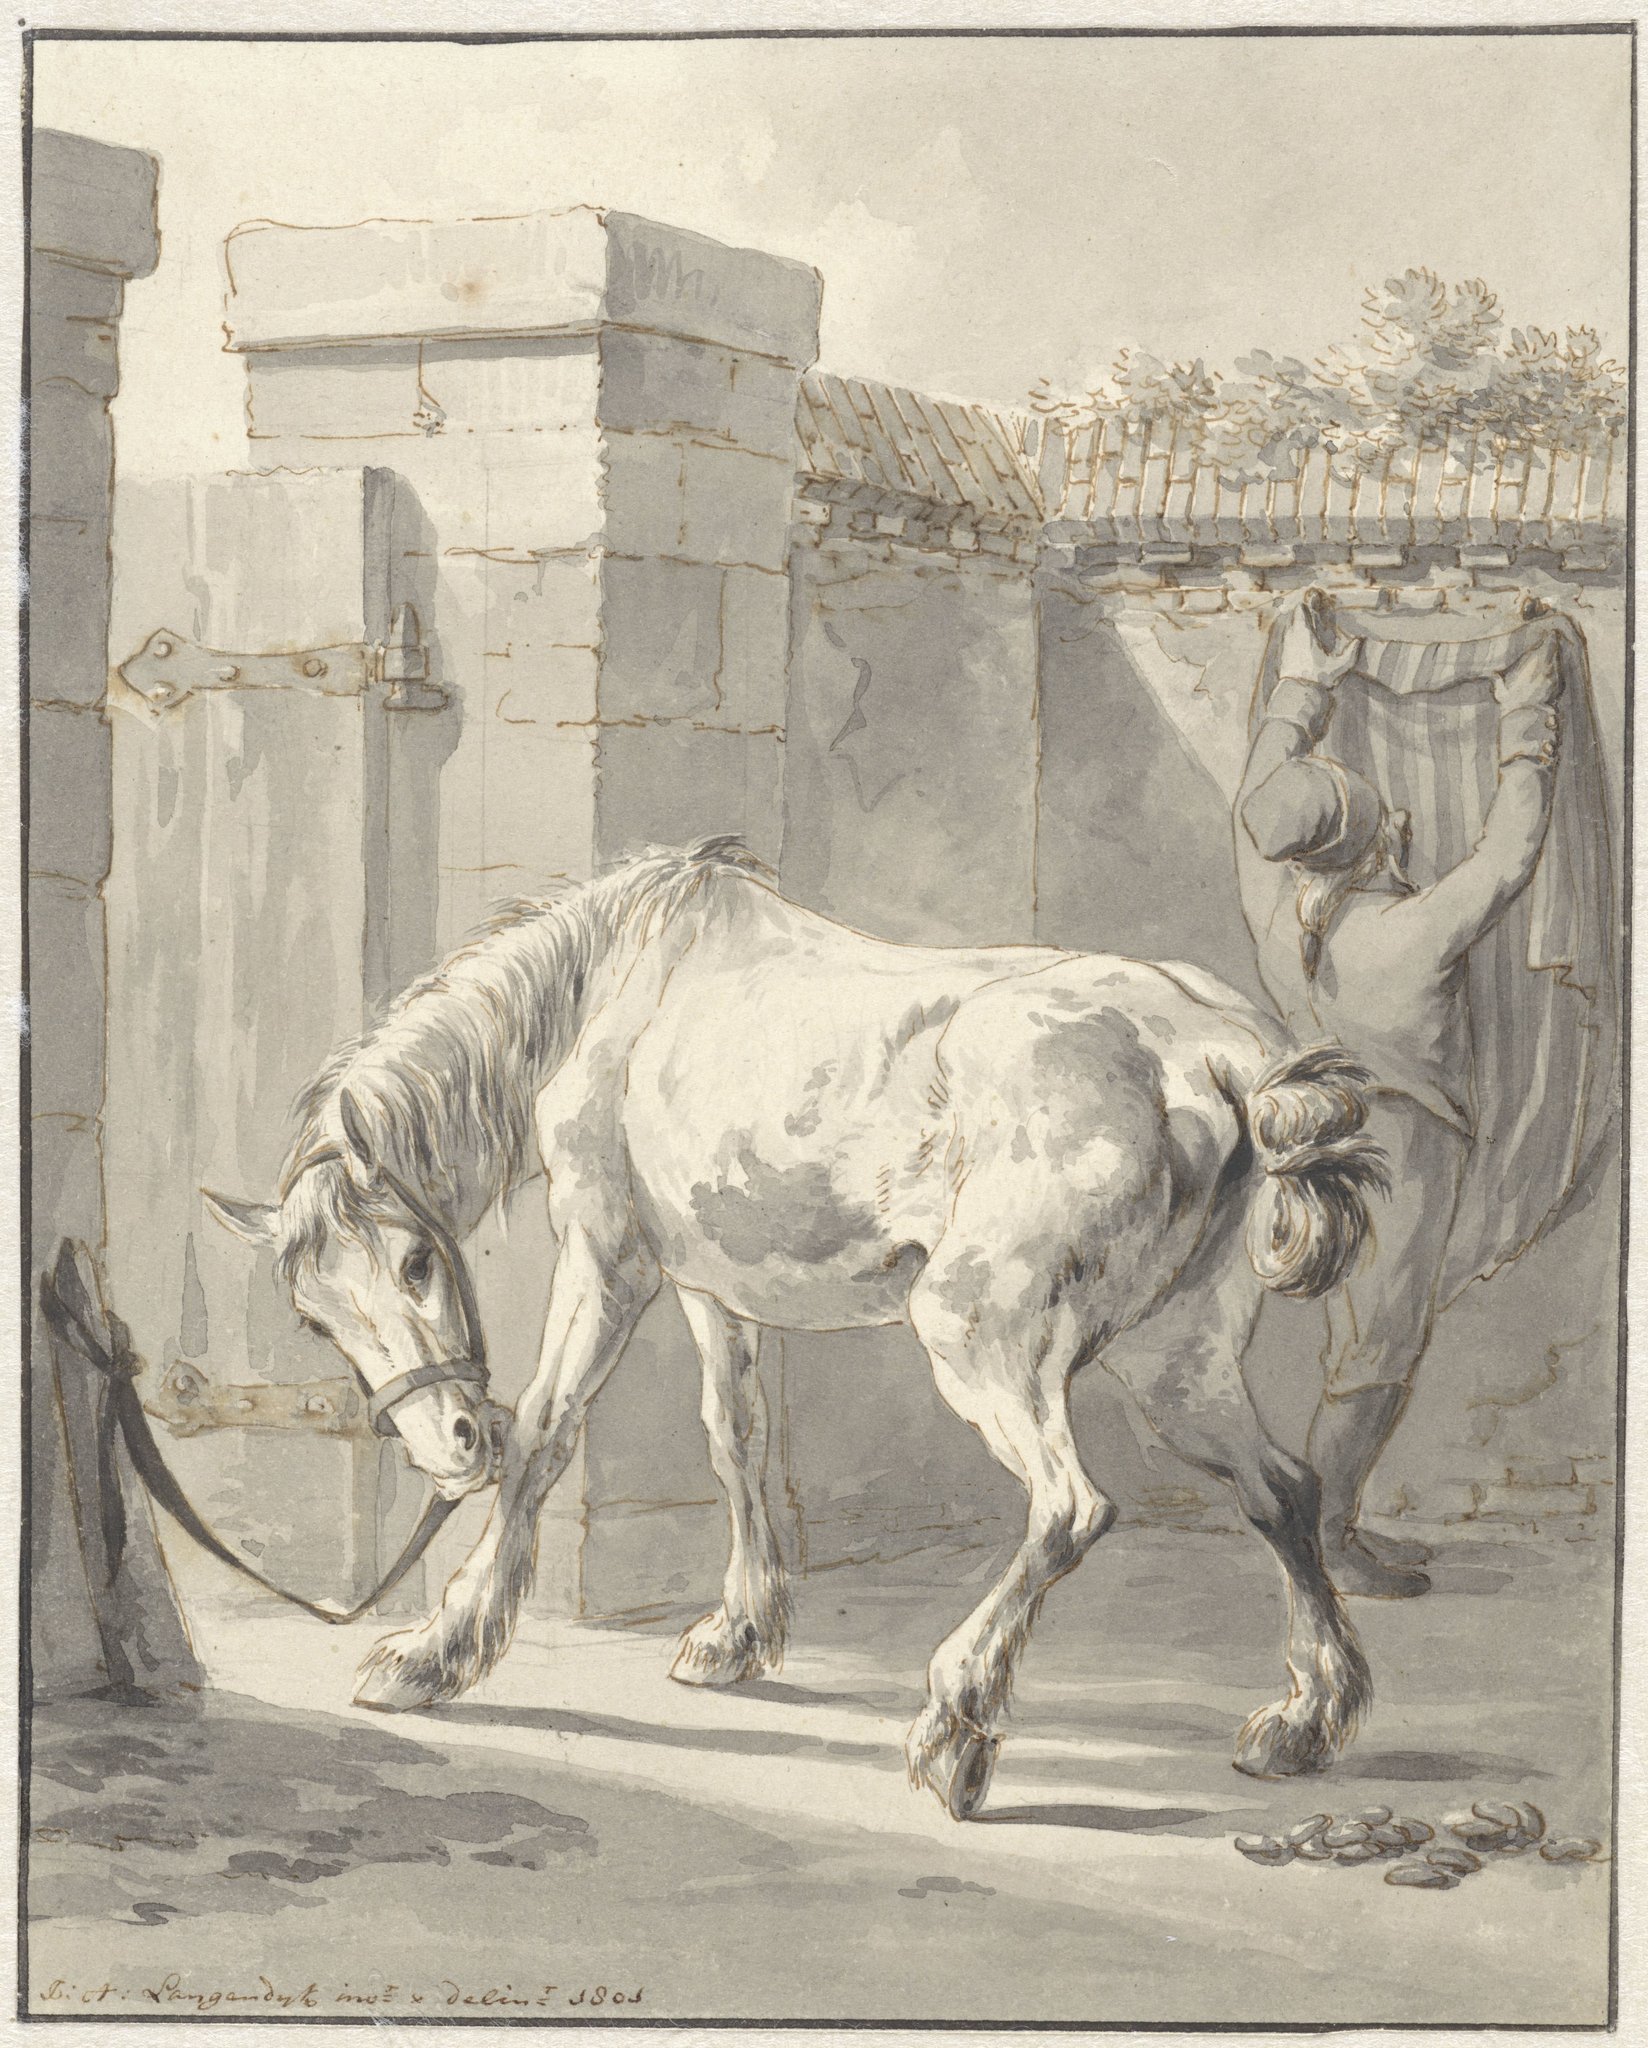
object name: drawing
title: Ongezadeld paard met de toom aan een paal vastgemaakt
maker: jan anthonie langendijk dzn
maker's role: draughtsman, print maker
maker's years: 1780-1818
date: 1801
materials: ink, paper, pencil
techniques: brush, pen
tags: horse